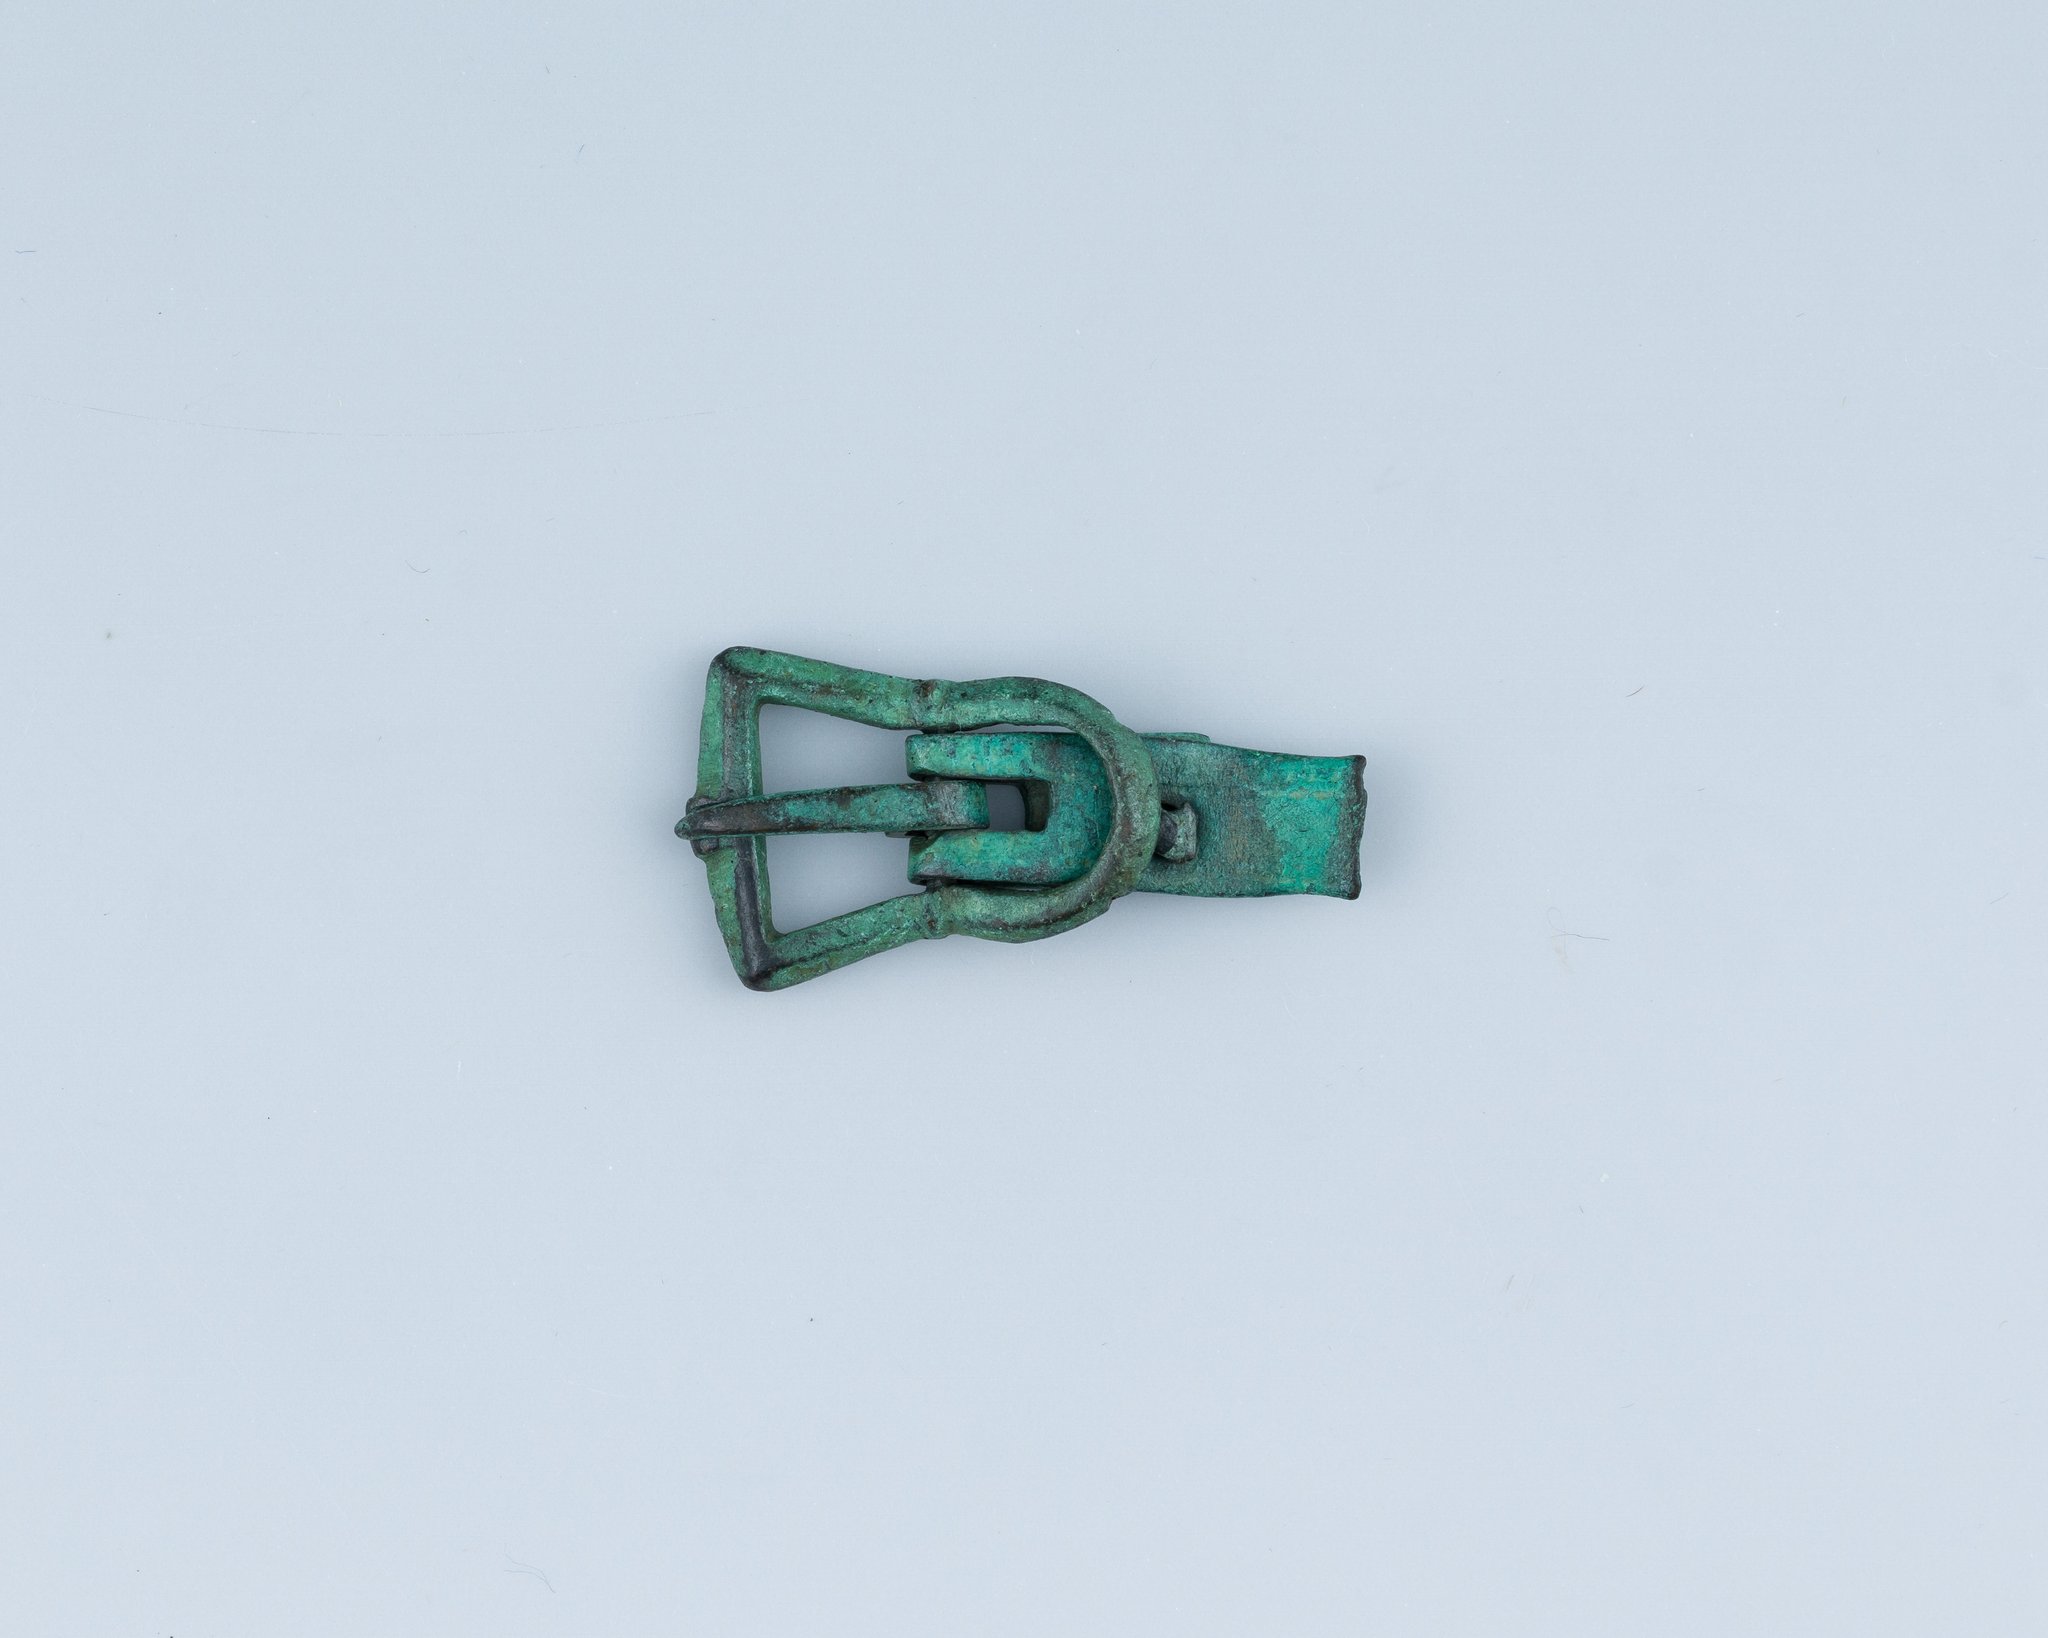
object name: buckle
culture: european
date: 1401-1600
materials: bronze, patina